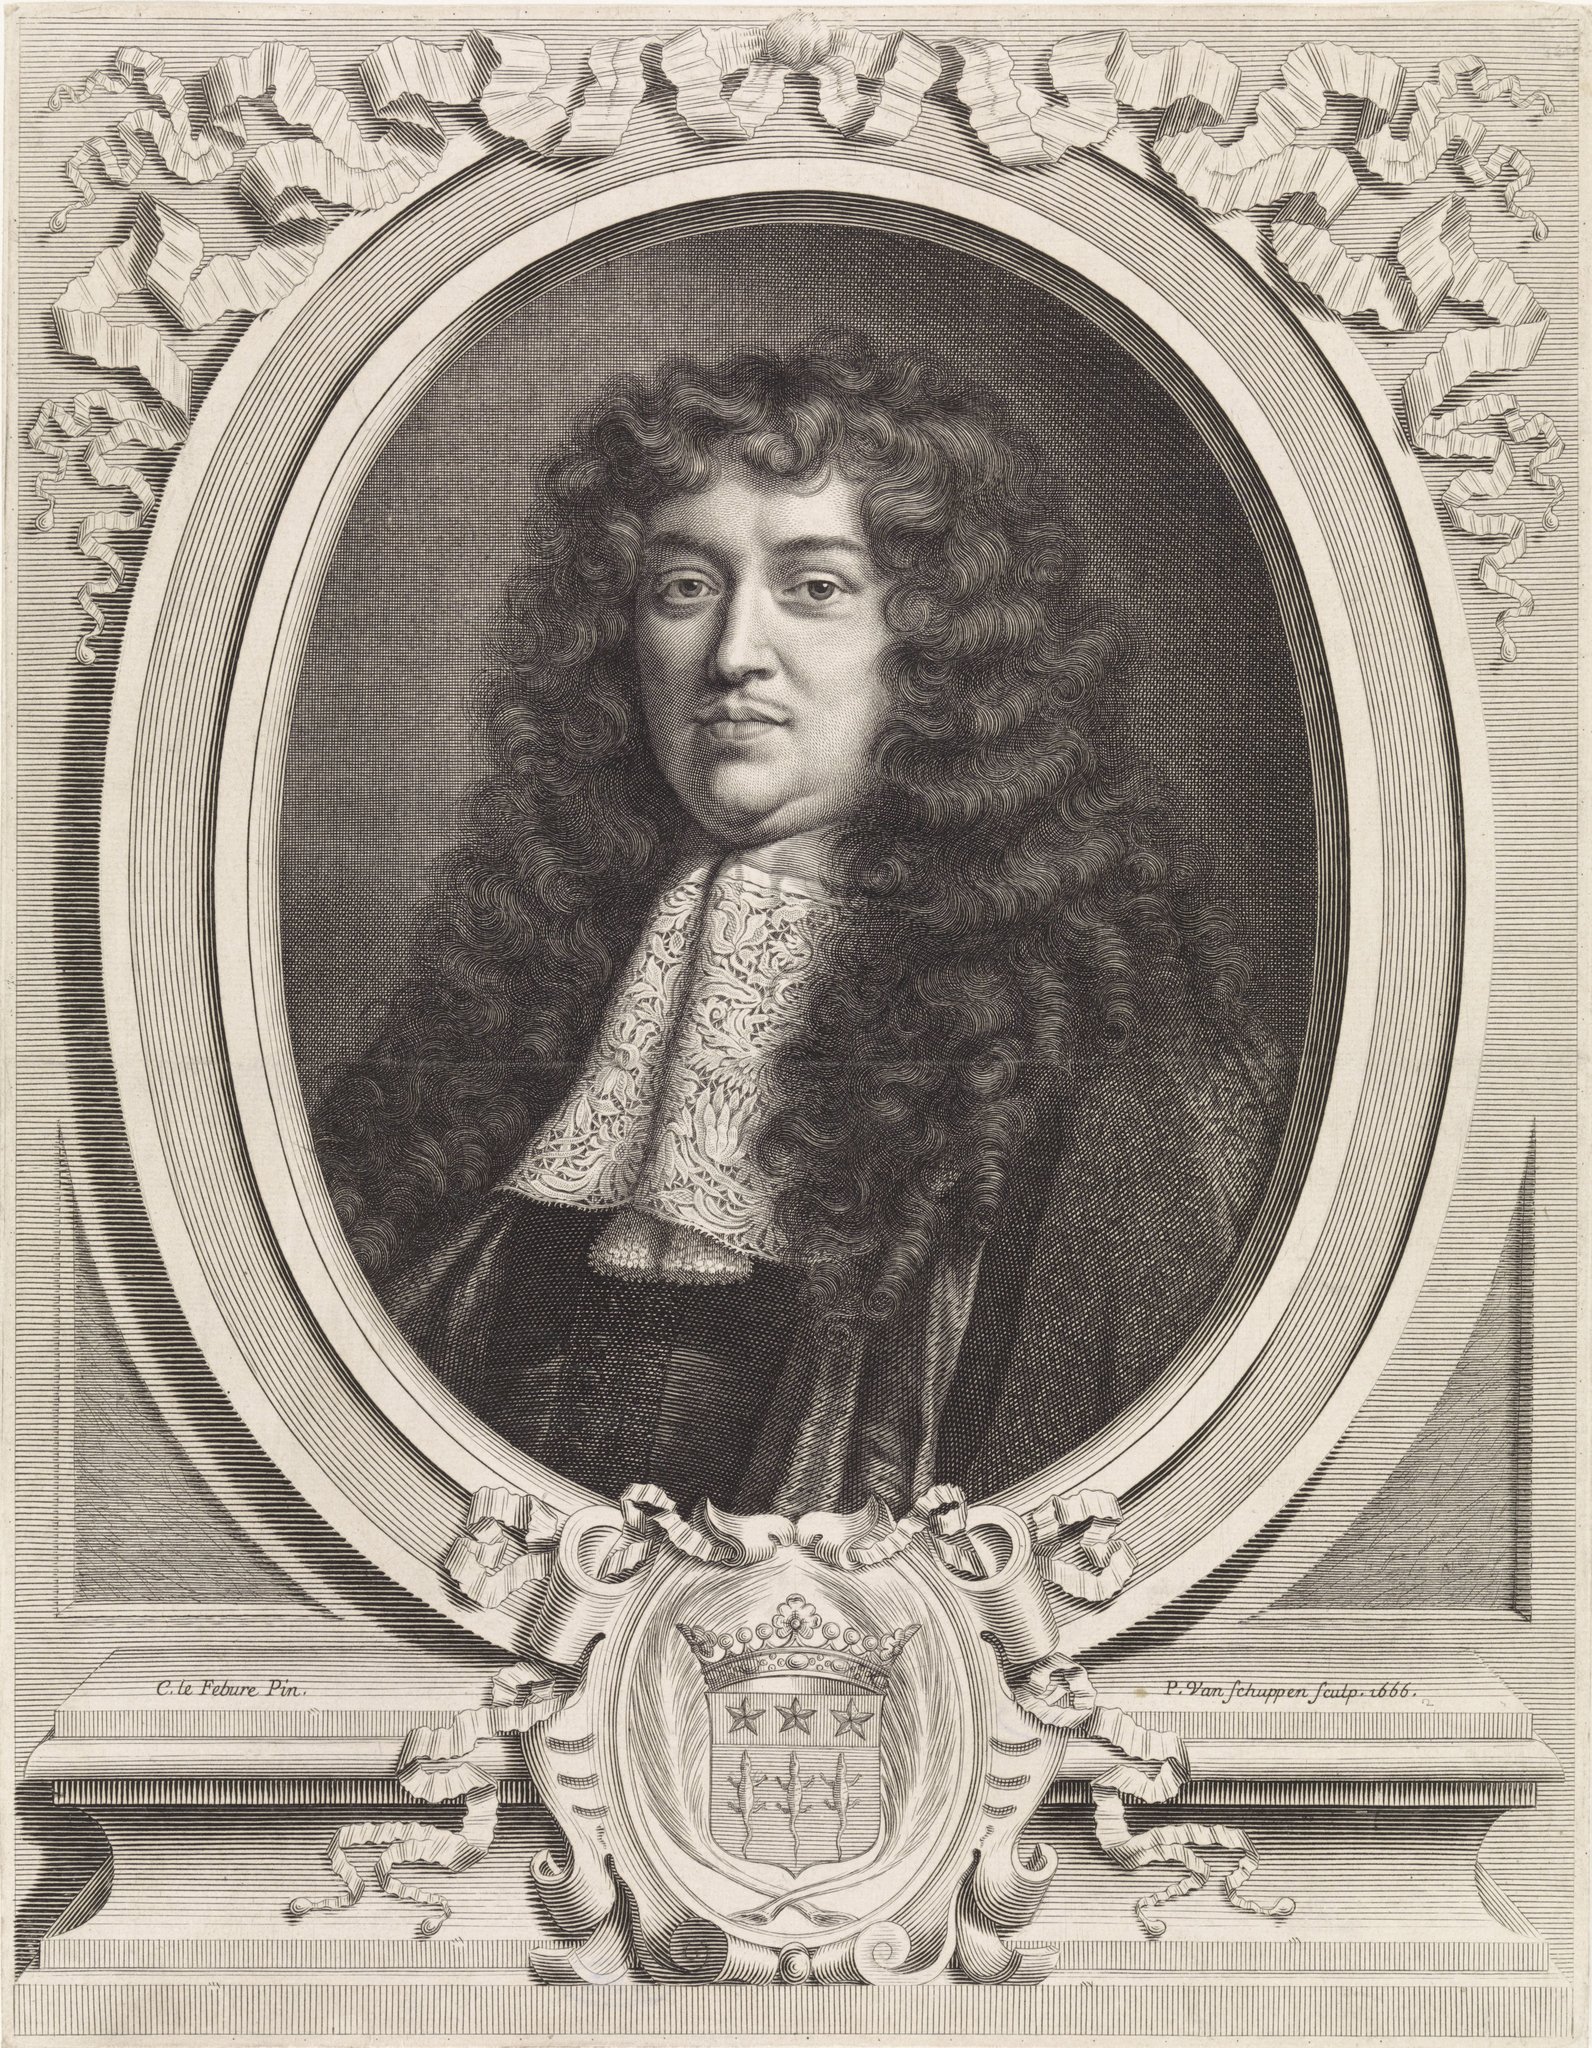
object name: print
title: Portret van François-Michel le Tellier, markies van Louvois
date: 1602-1666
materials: paper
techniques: engraving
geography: paris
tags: paris, françois-michel le tellier (markies de louvois)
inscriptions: collector's mark: Lugt 2228